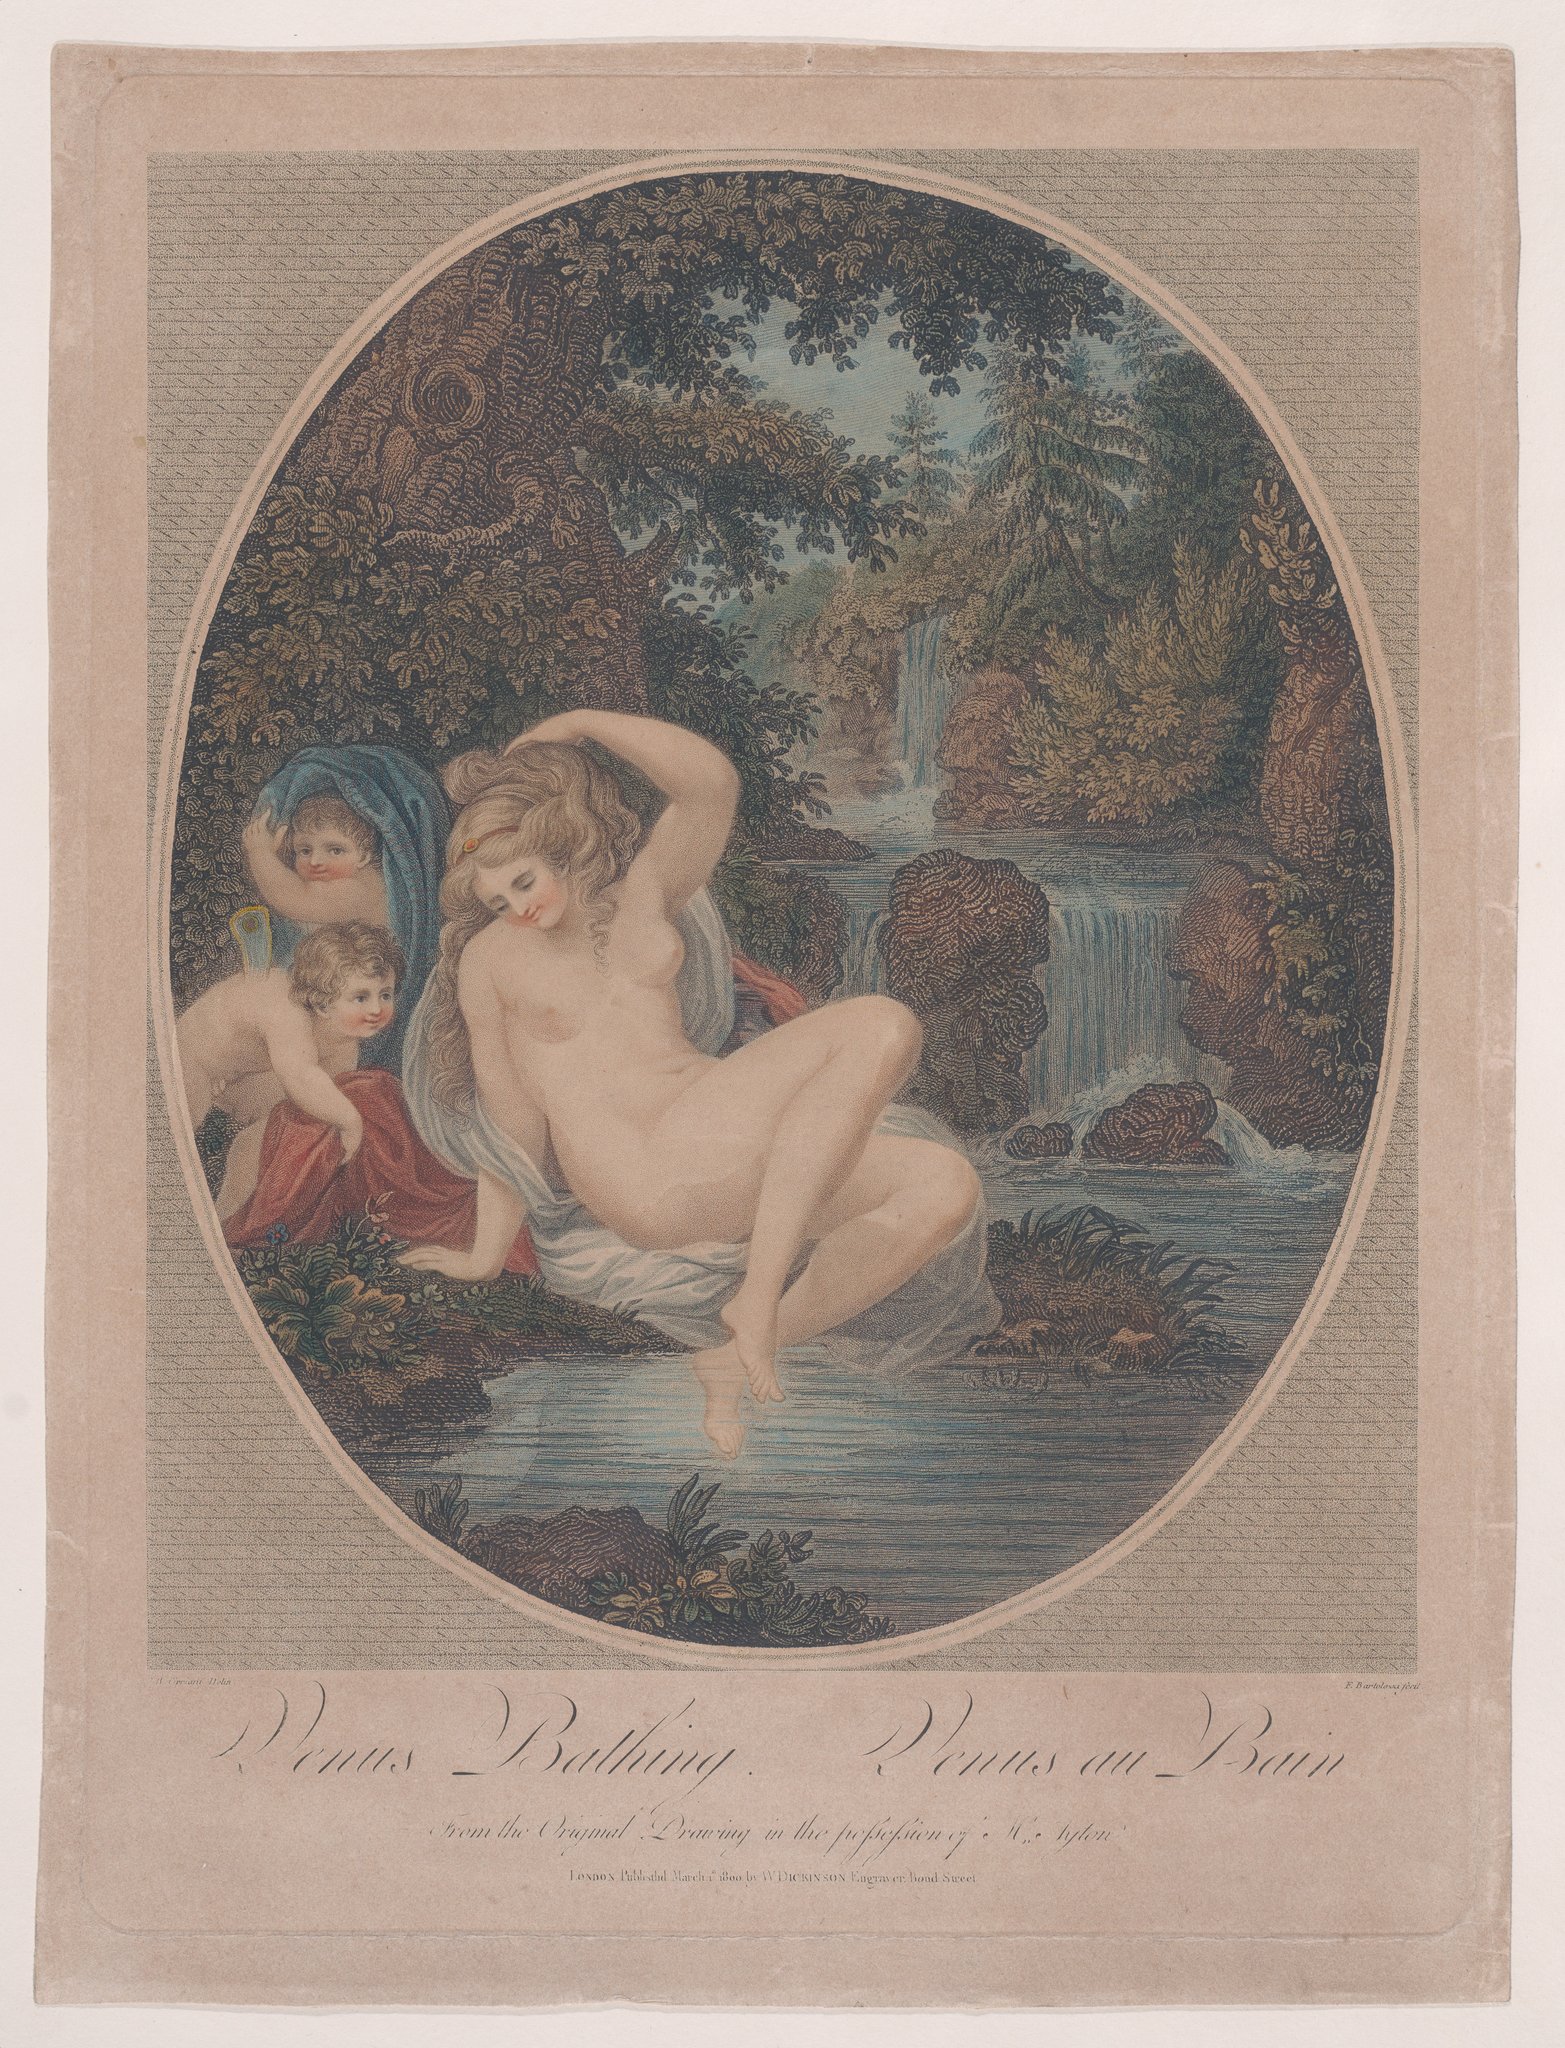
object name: print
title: Venus Bathing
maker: francesco bartolozzi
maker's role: artist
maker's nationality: italian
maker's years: 1728-1815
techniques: etching, printing, engraving